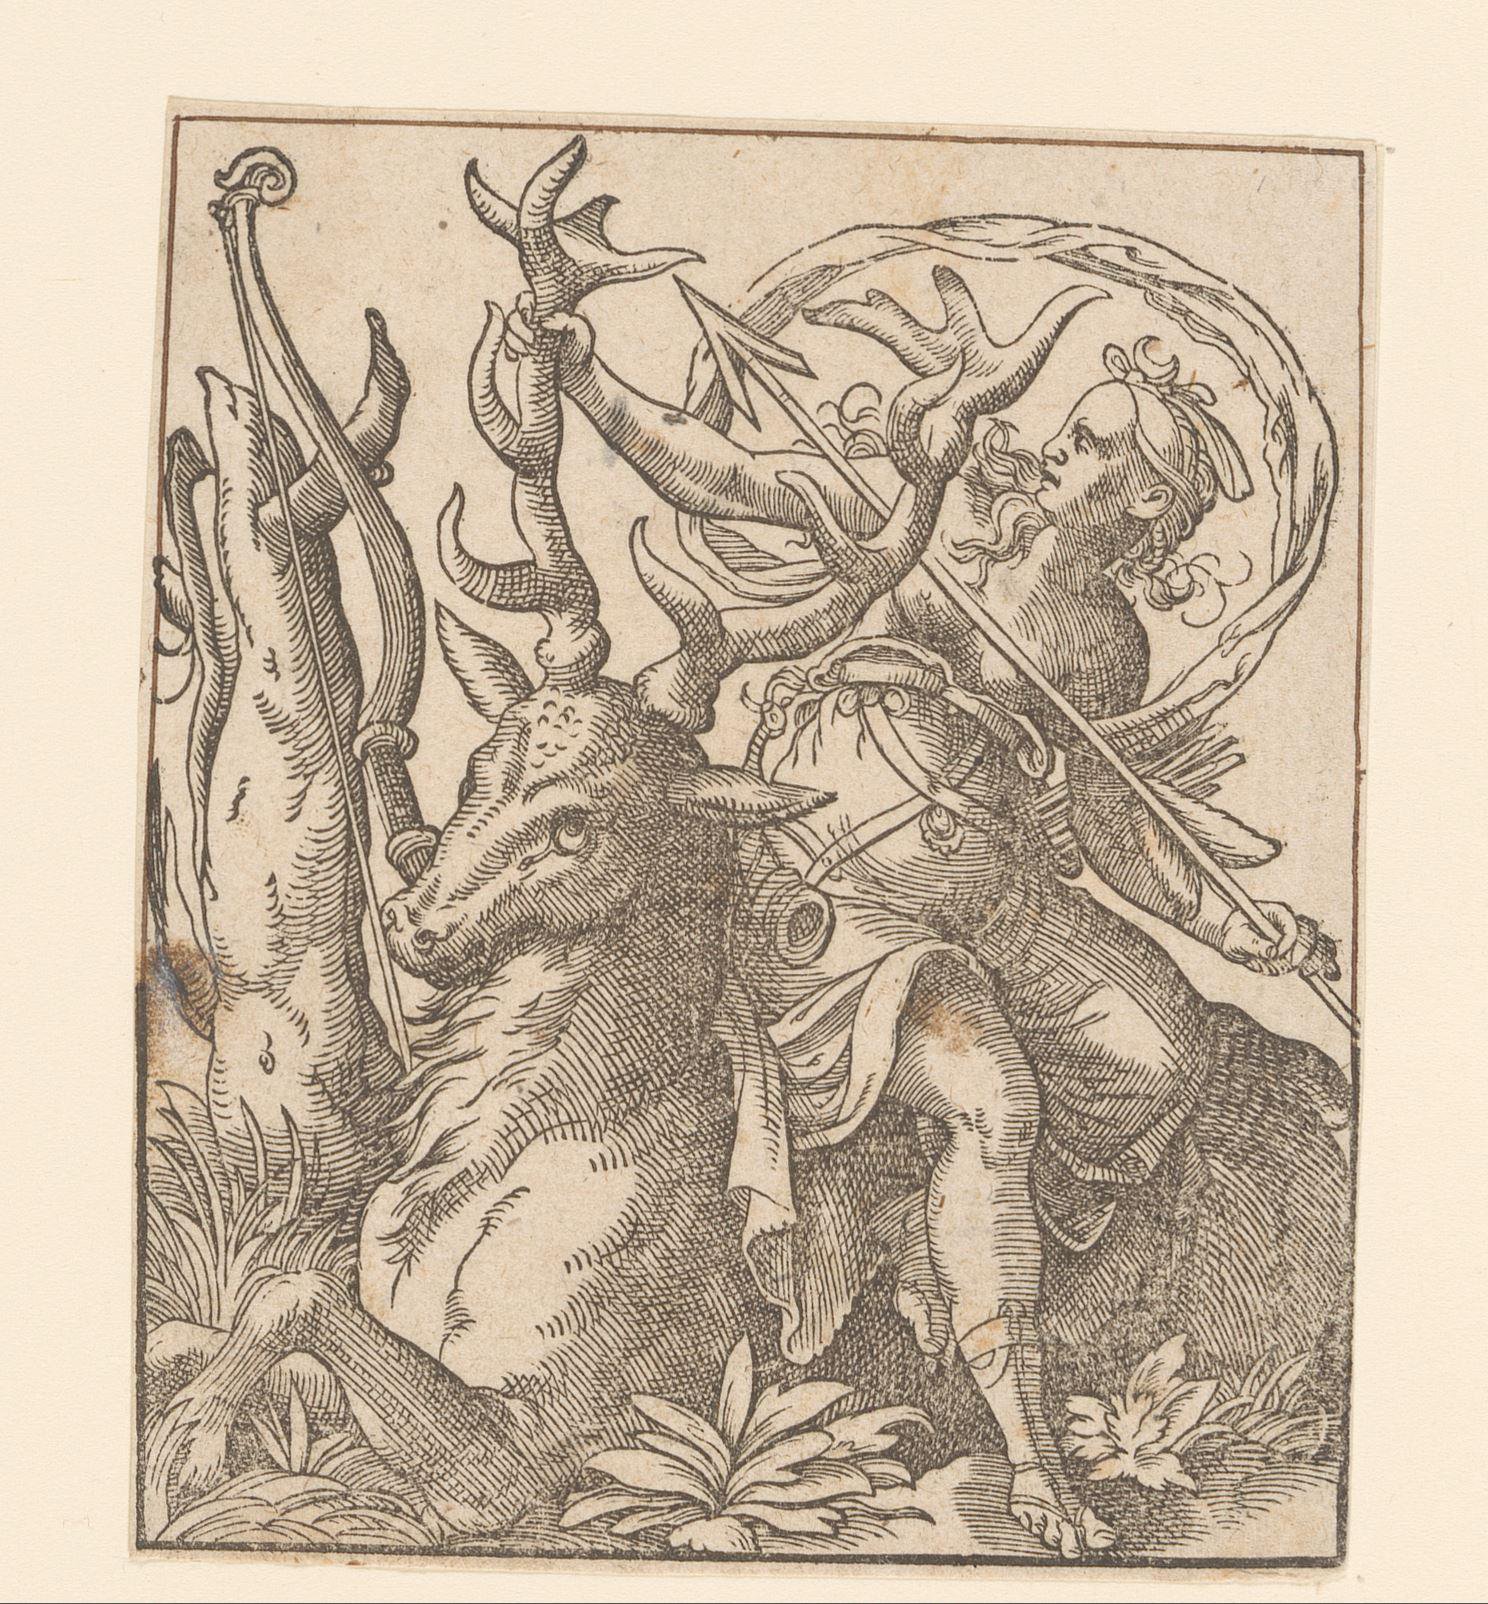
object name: print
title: Diana zittend op een hert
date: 1580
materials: paper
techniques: woodcut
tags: hoofed animals: deer, diana hunting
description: Prent ook gebruikt in: Amman, Jost. Kunstbüchlein. Frankfurt am Main: Feyerabend, 1580.